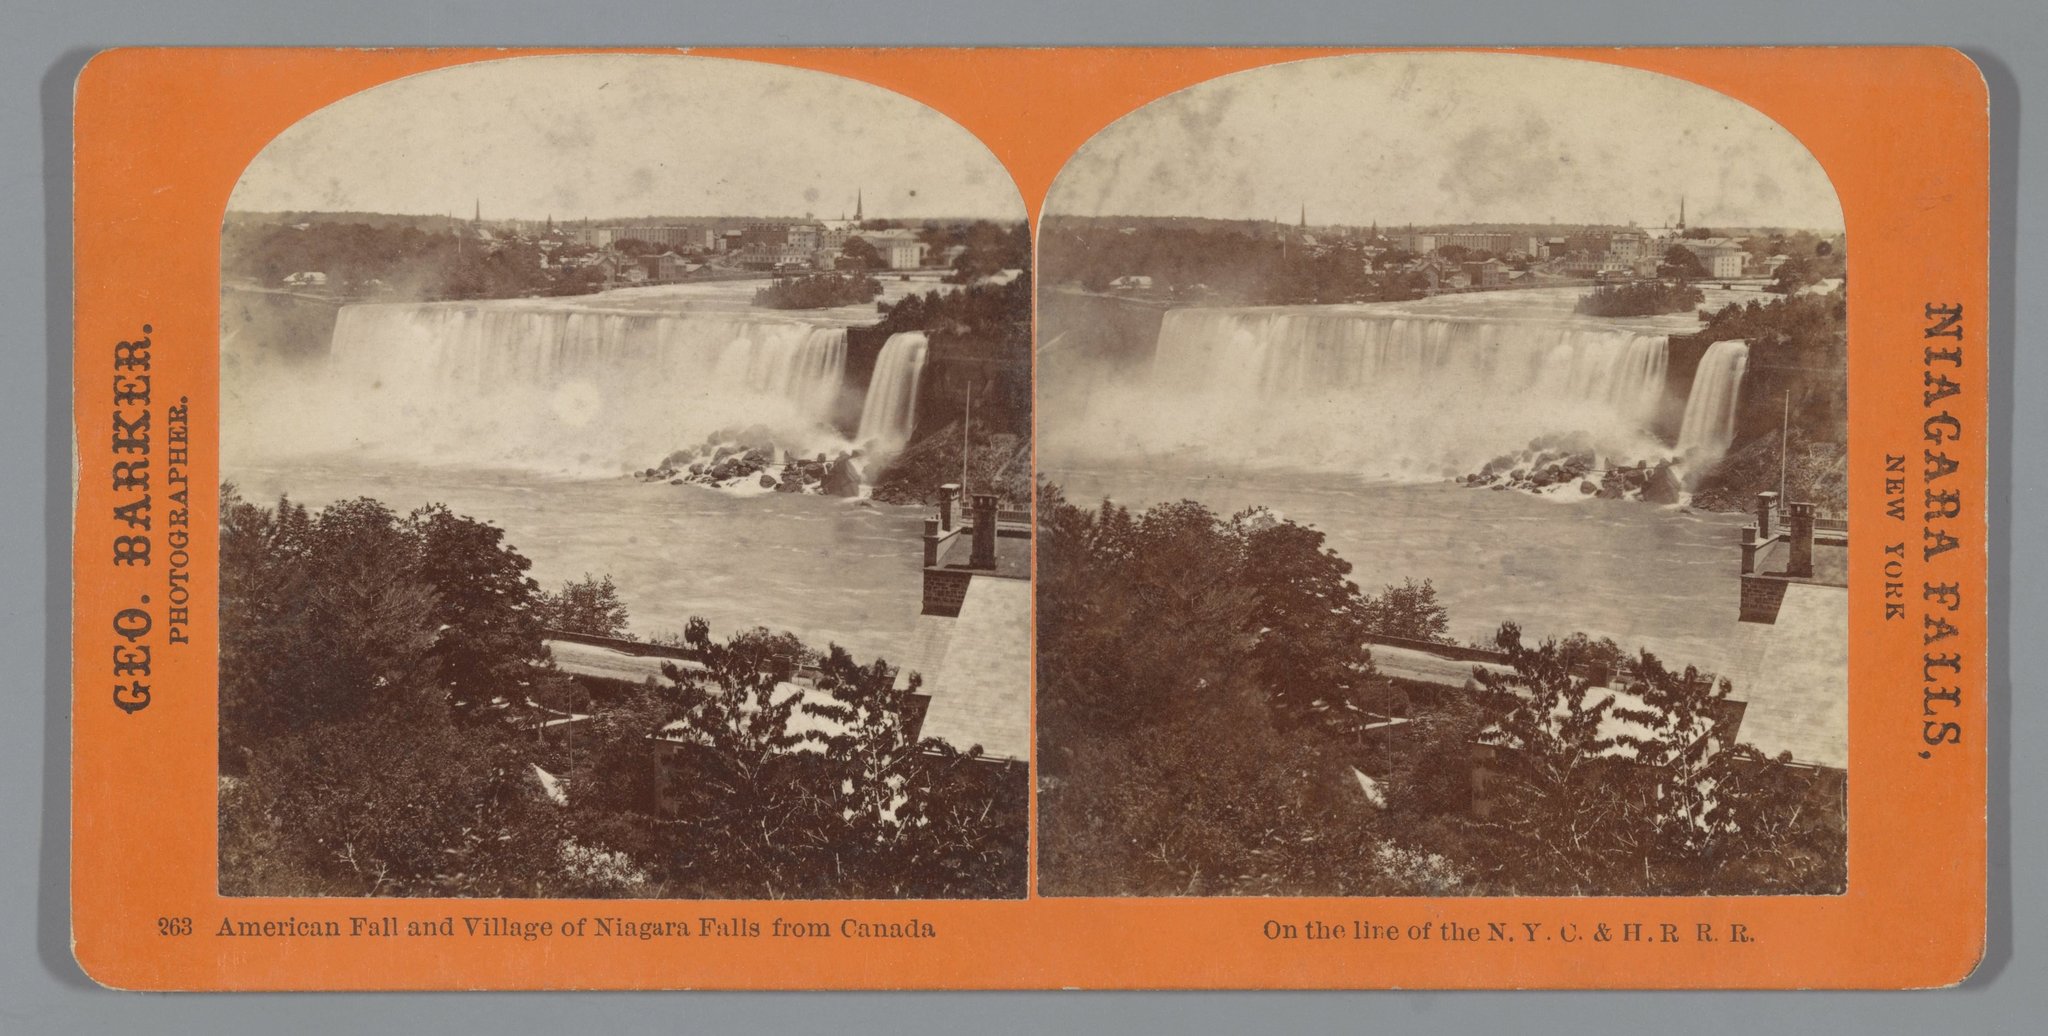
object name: stereograph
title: American Fall and Village of Niagara Falls from Canada, On the line of the N.Y.C. and H.R.R.R.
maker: george barker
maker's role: fotograaf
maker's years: 1844-1894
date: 1863-1894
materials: cardboard, paper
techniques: albumen print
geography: niagara falls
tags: waterfall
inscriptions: number: ‘263’, inscription: ‘2/3’